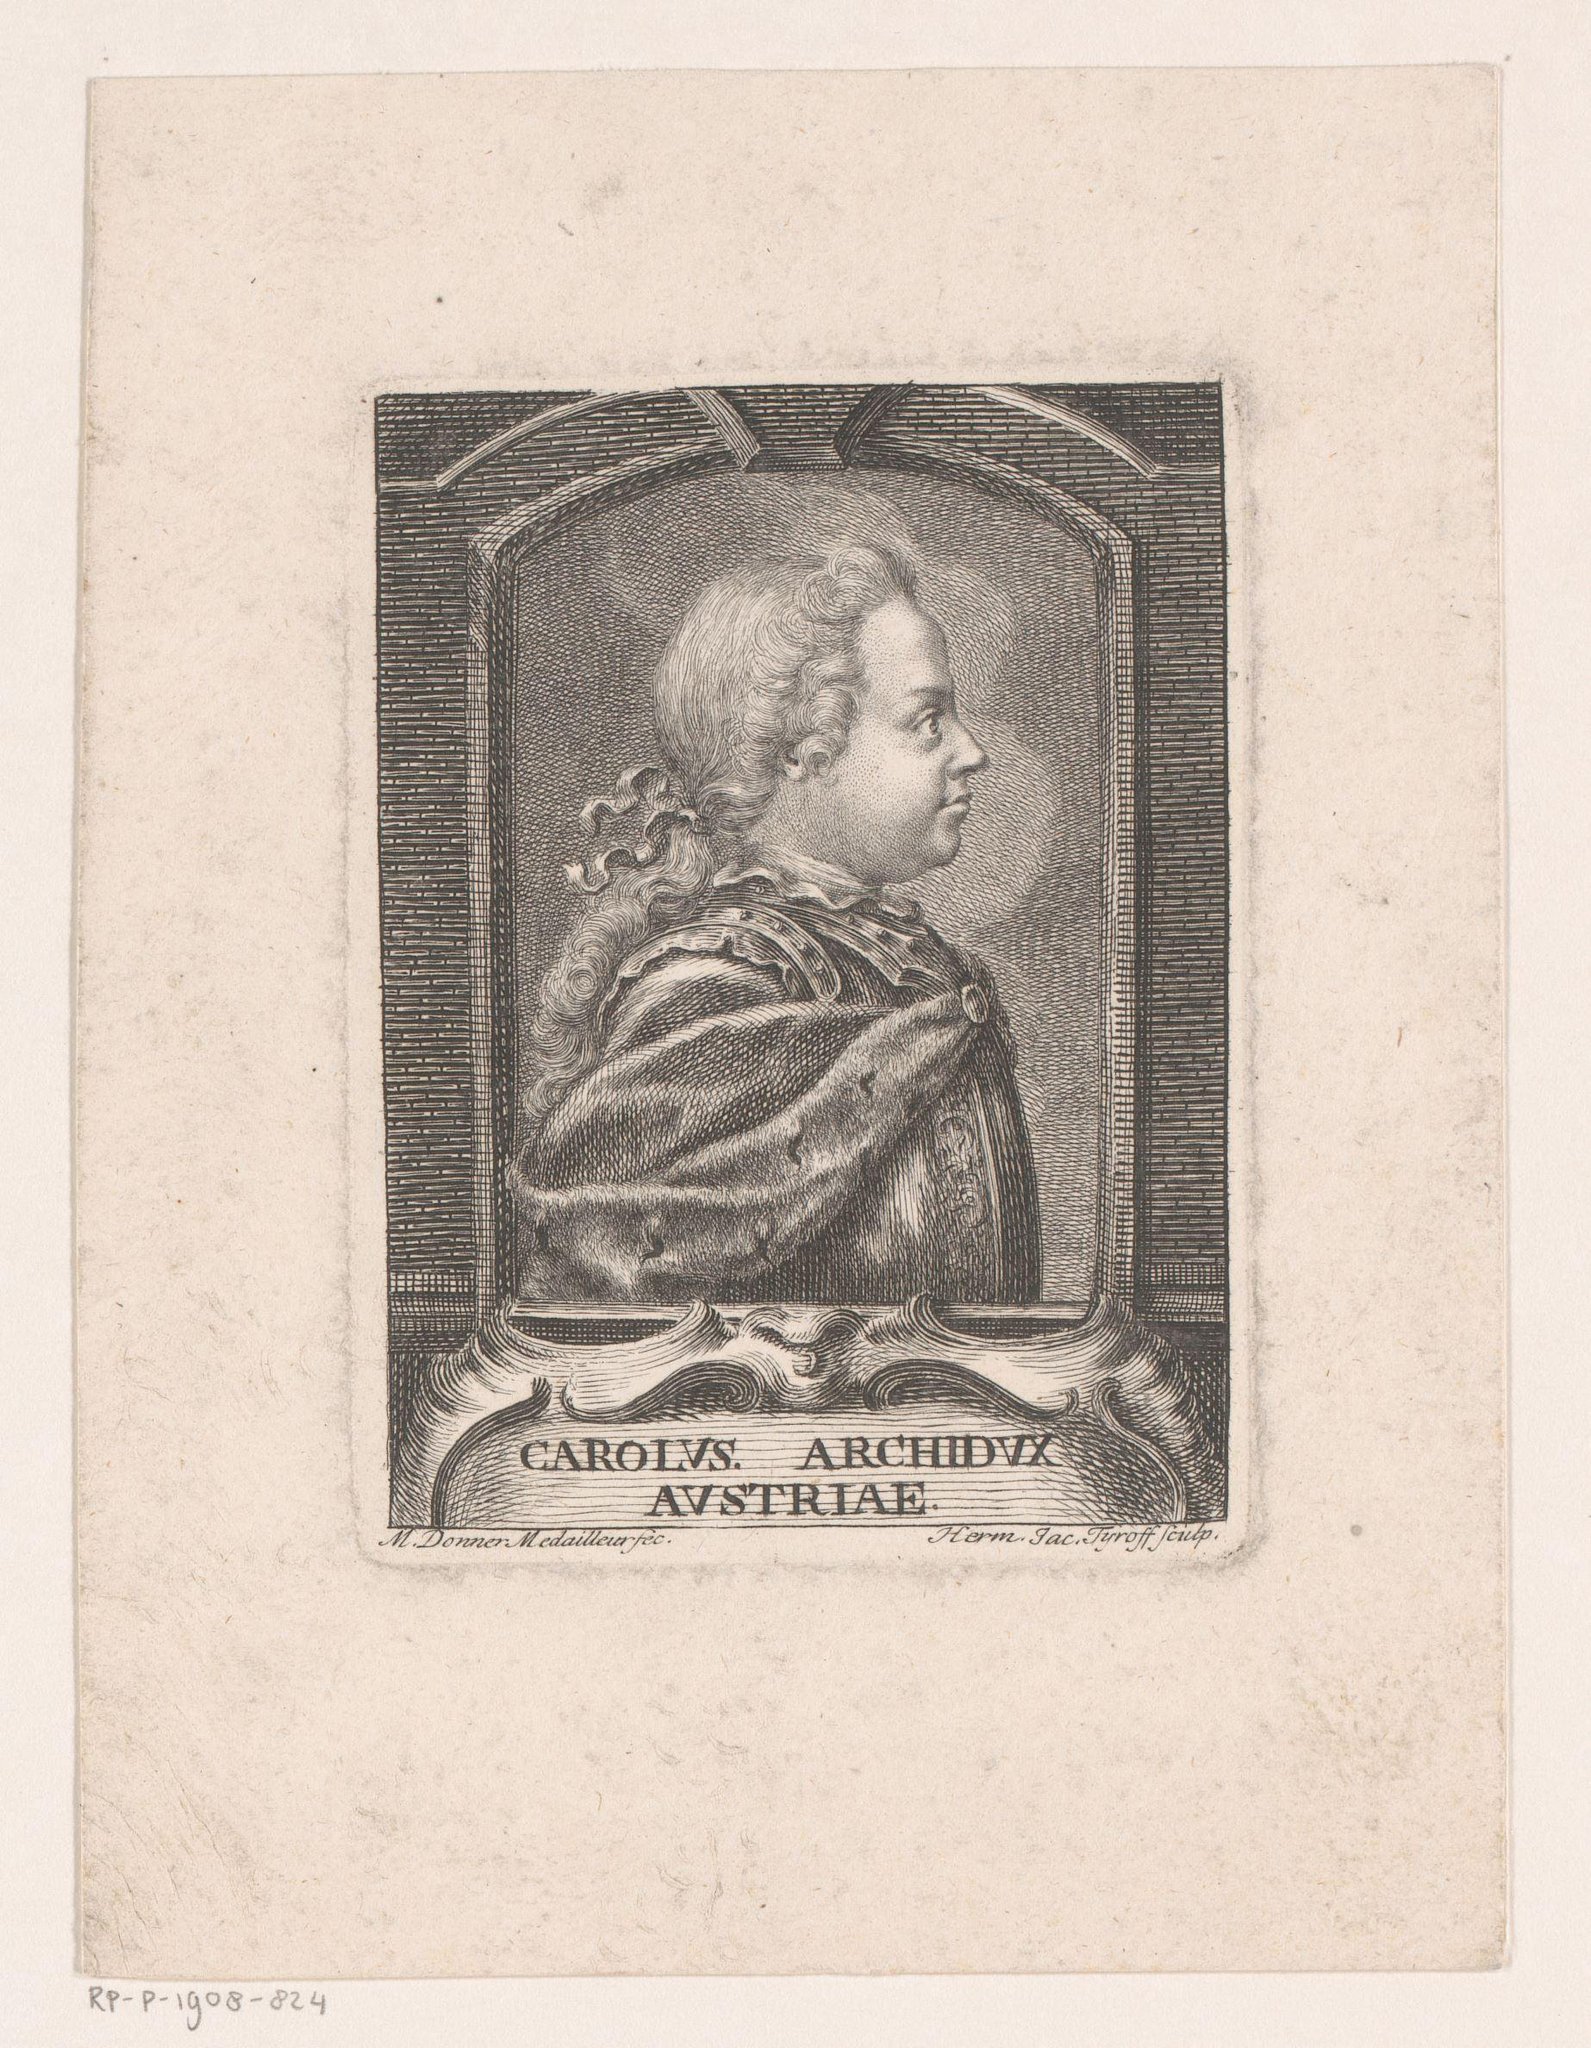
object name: print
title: Portret van Karel van Oostenrijk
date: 1780-1798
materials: paper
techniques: etching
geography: germany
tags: historical persons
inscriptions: collector's mark: Lugt 2228